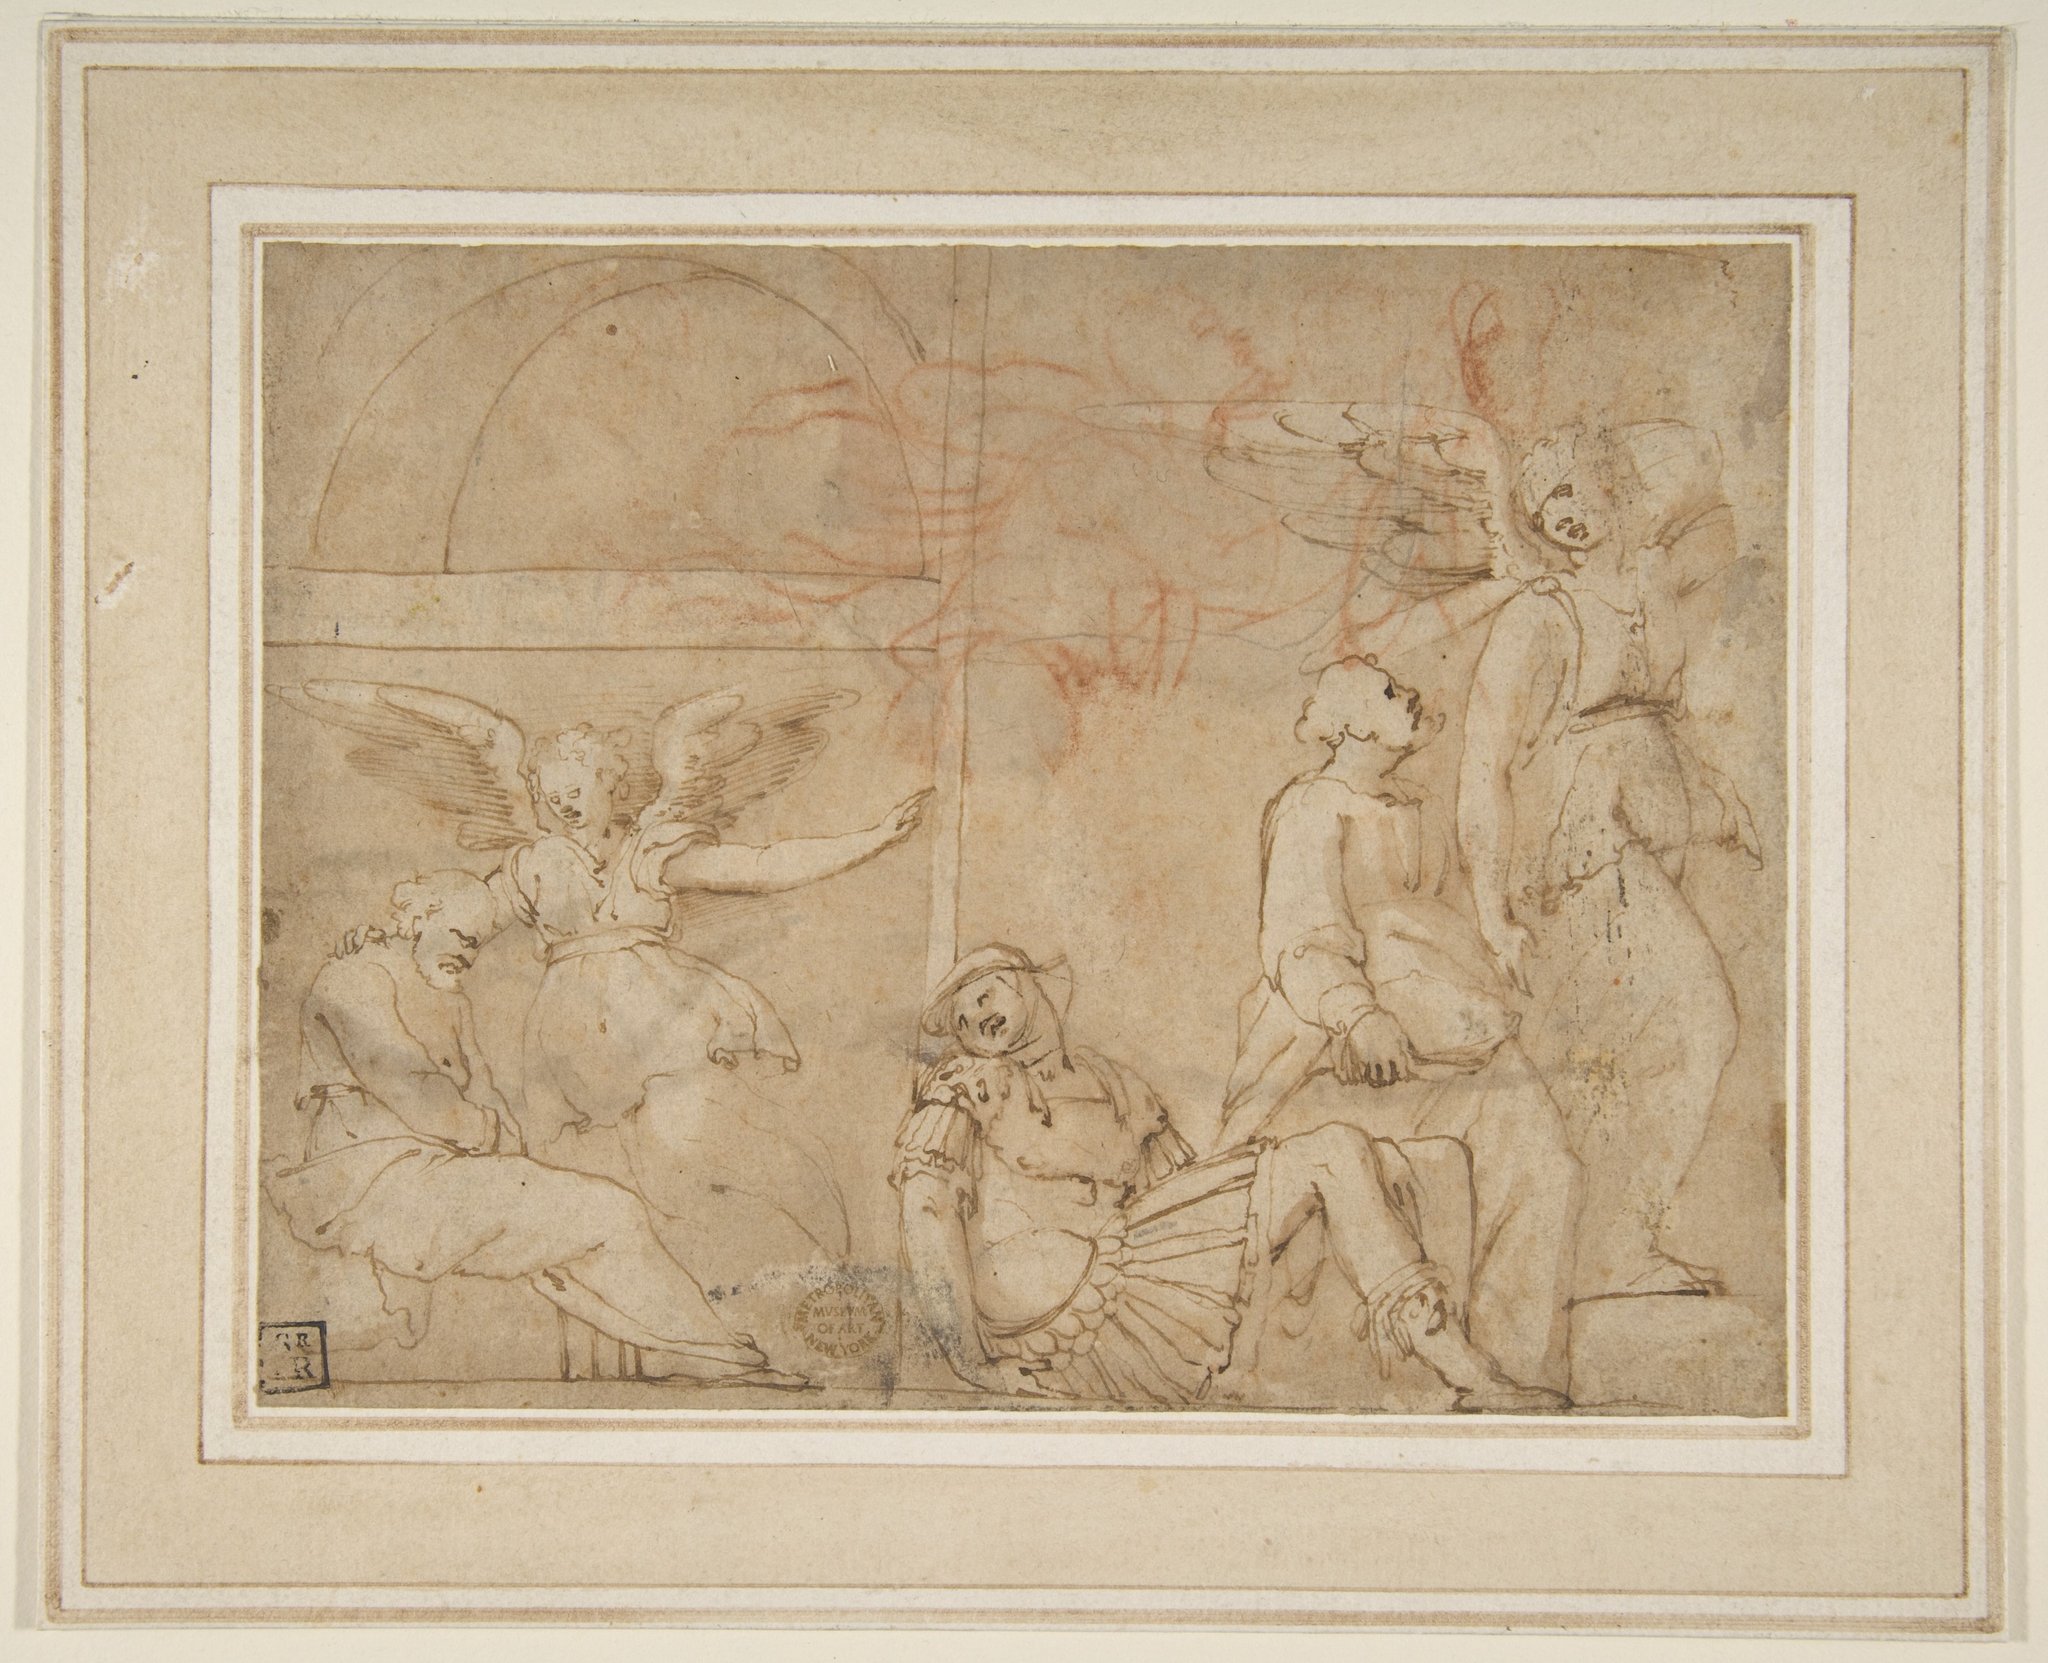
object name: drawing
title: St. Peter Delivered from Prison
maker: polidoro da caravaggio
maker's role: artist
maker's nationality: italian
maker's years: 1494-1548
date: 1499-1543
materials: chalk, ink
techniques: brush, pen, wash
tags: angels,saint peter